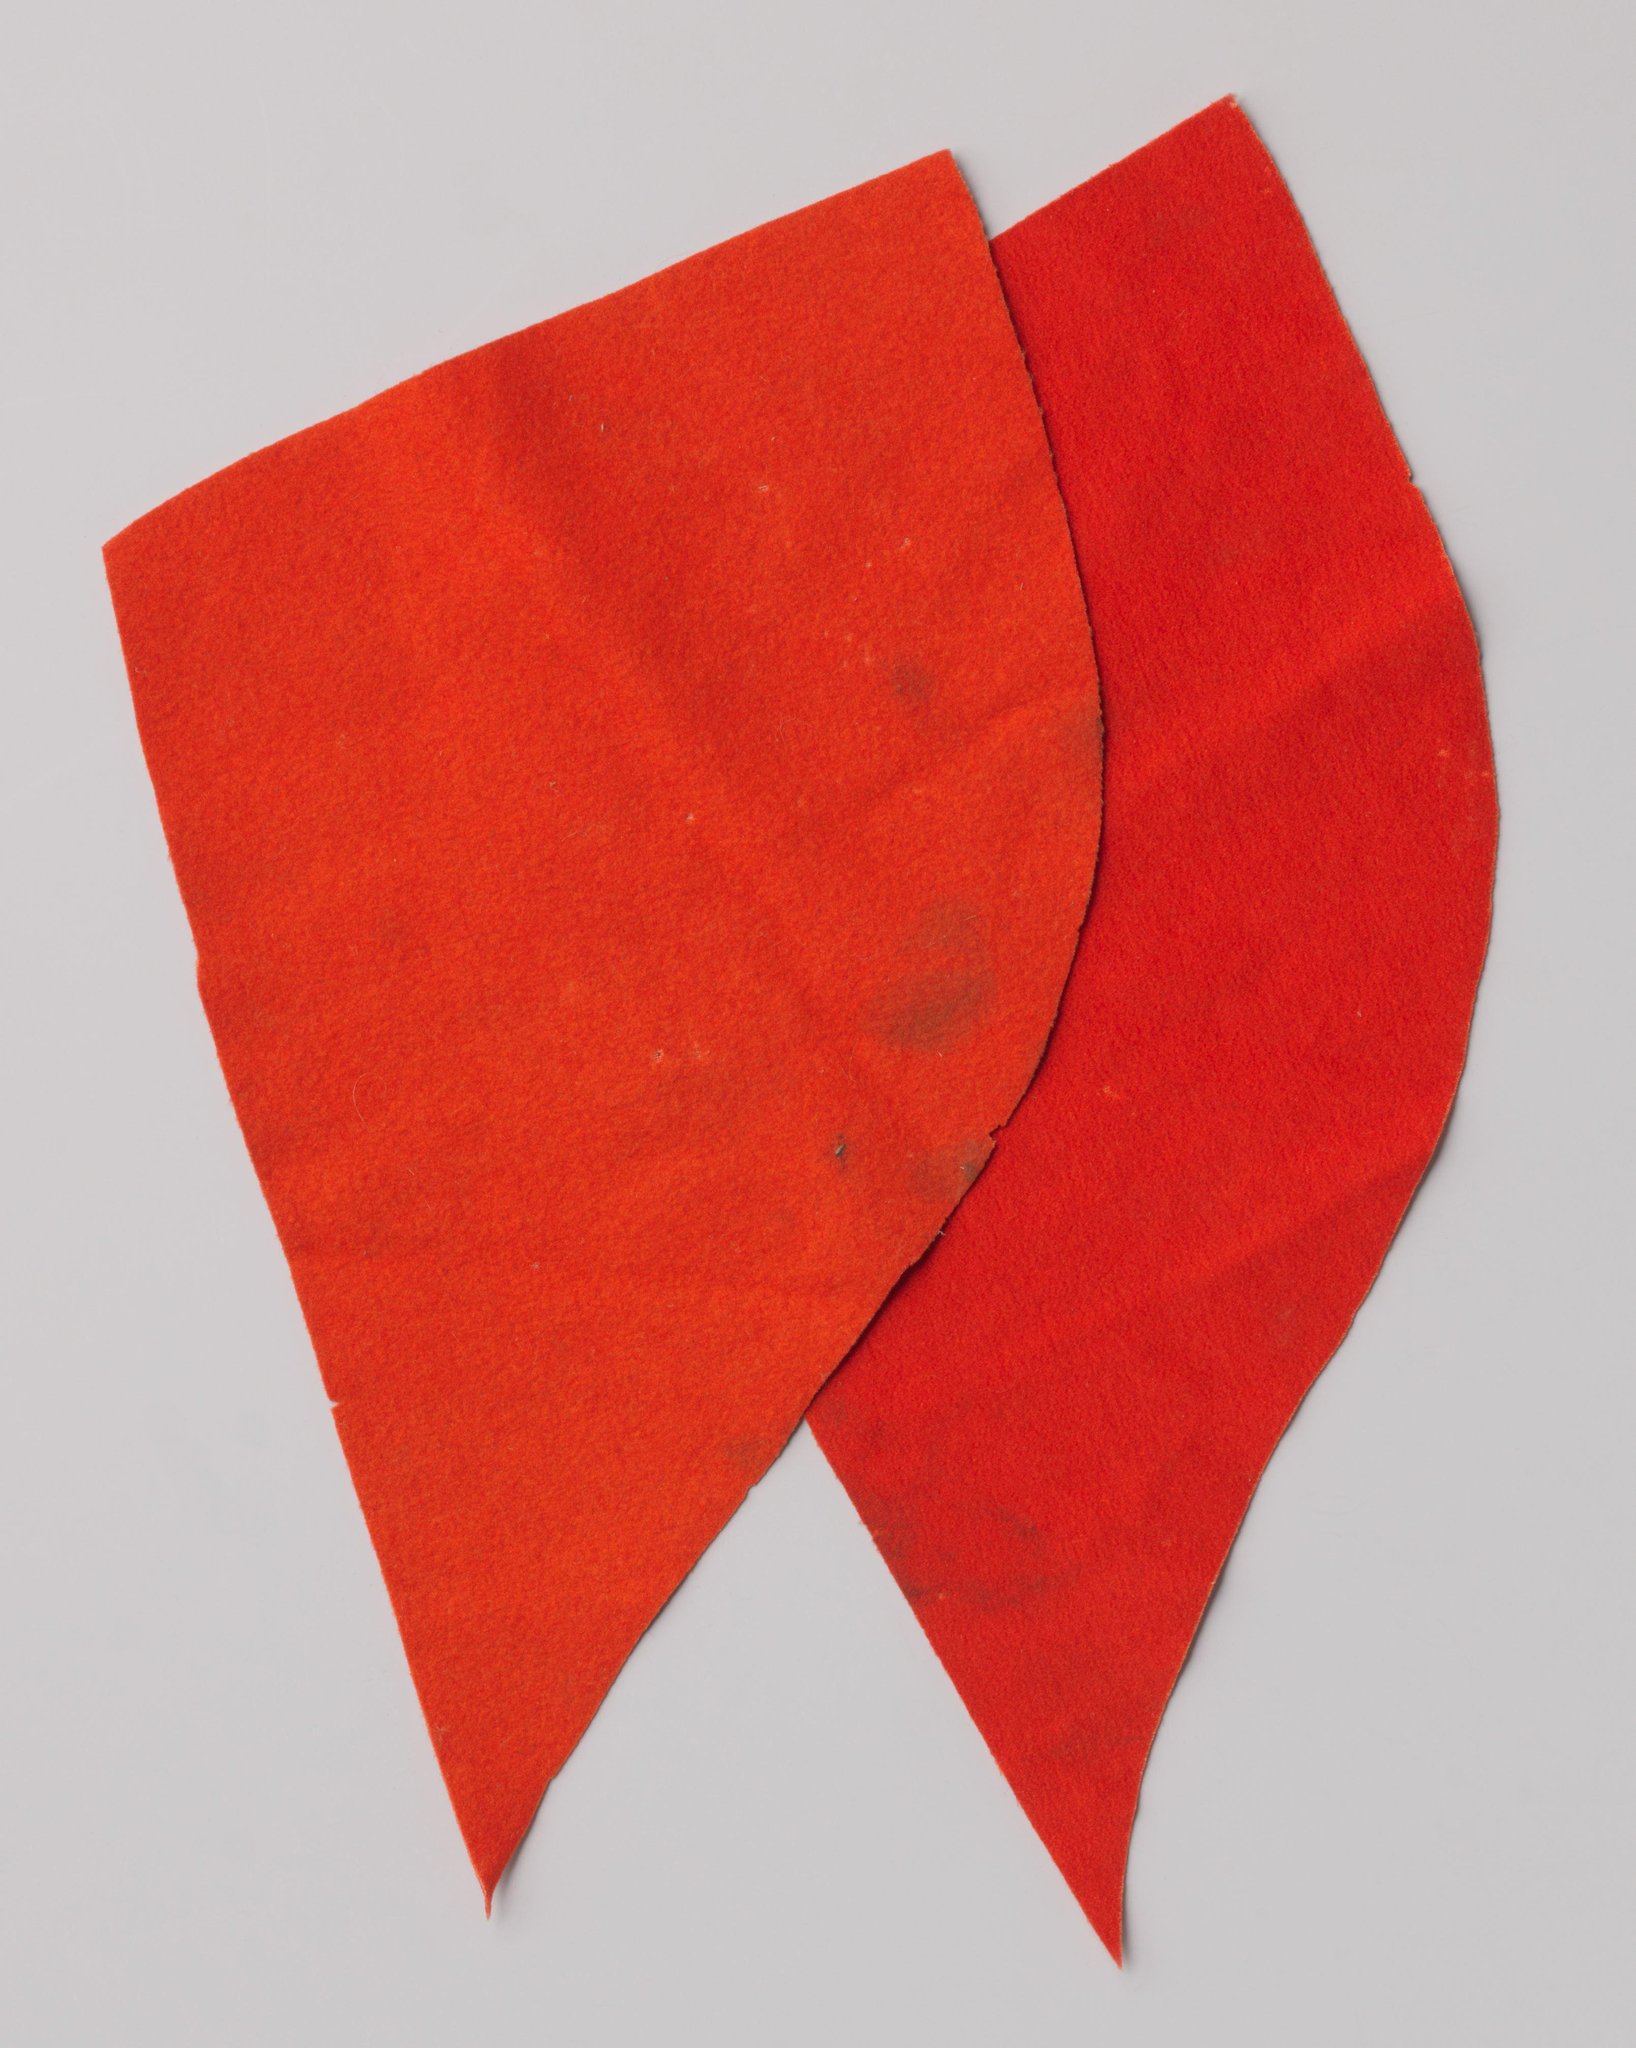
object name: coupon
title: Ponceaurood, fijn laken in twee stukken van 1/4 cirkel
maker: Anonymous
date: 1800-1850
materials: textile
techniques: weave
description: Twee stukken ponceaurood, fijn laken, 1/4 van cirkel. Vermoedelijk uitmonsteringslaken voor biezen. In pakket met etiket: Rijksmuseum, Amsterdam. Nederlandse leger, mariniers. Diverse stukjes uniformstof en/of uitmonsteringslaken.